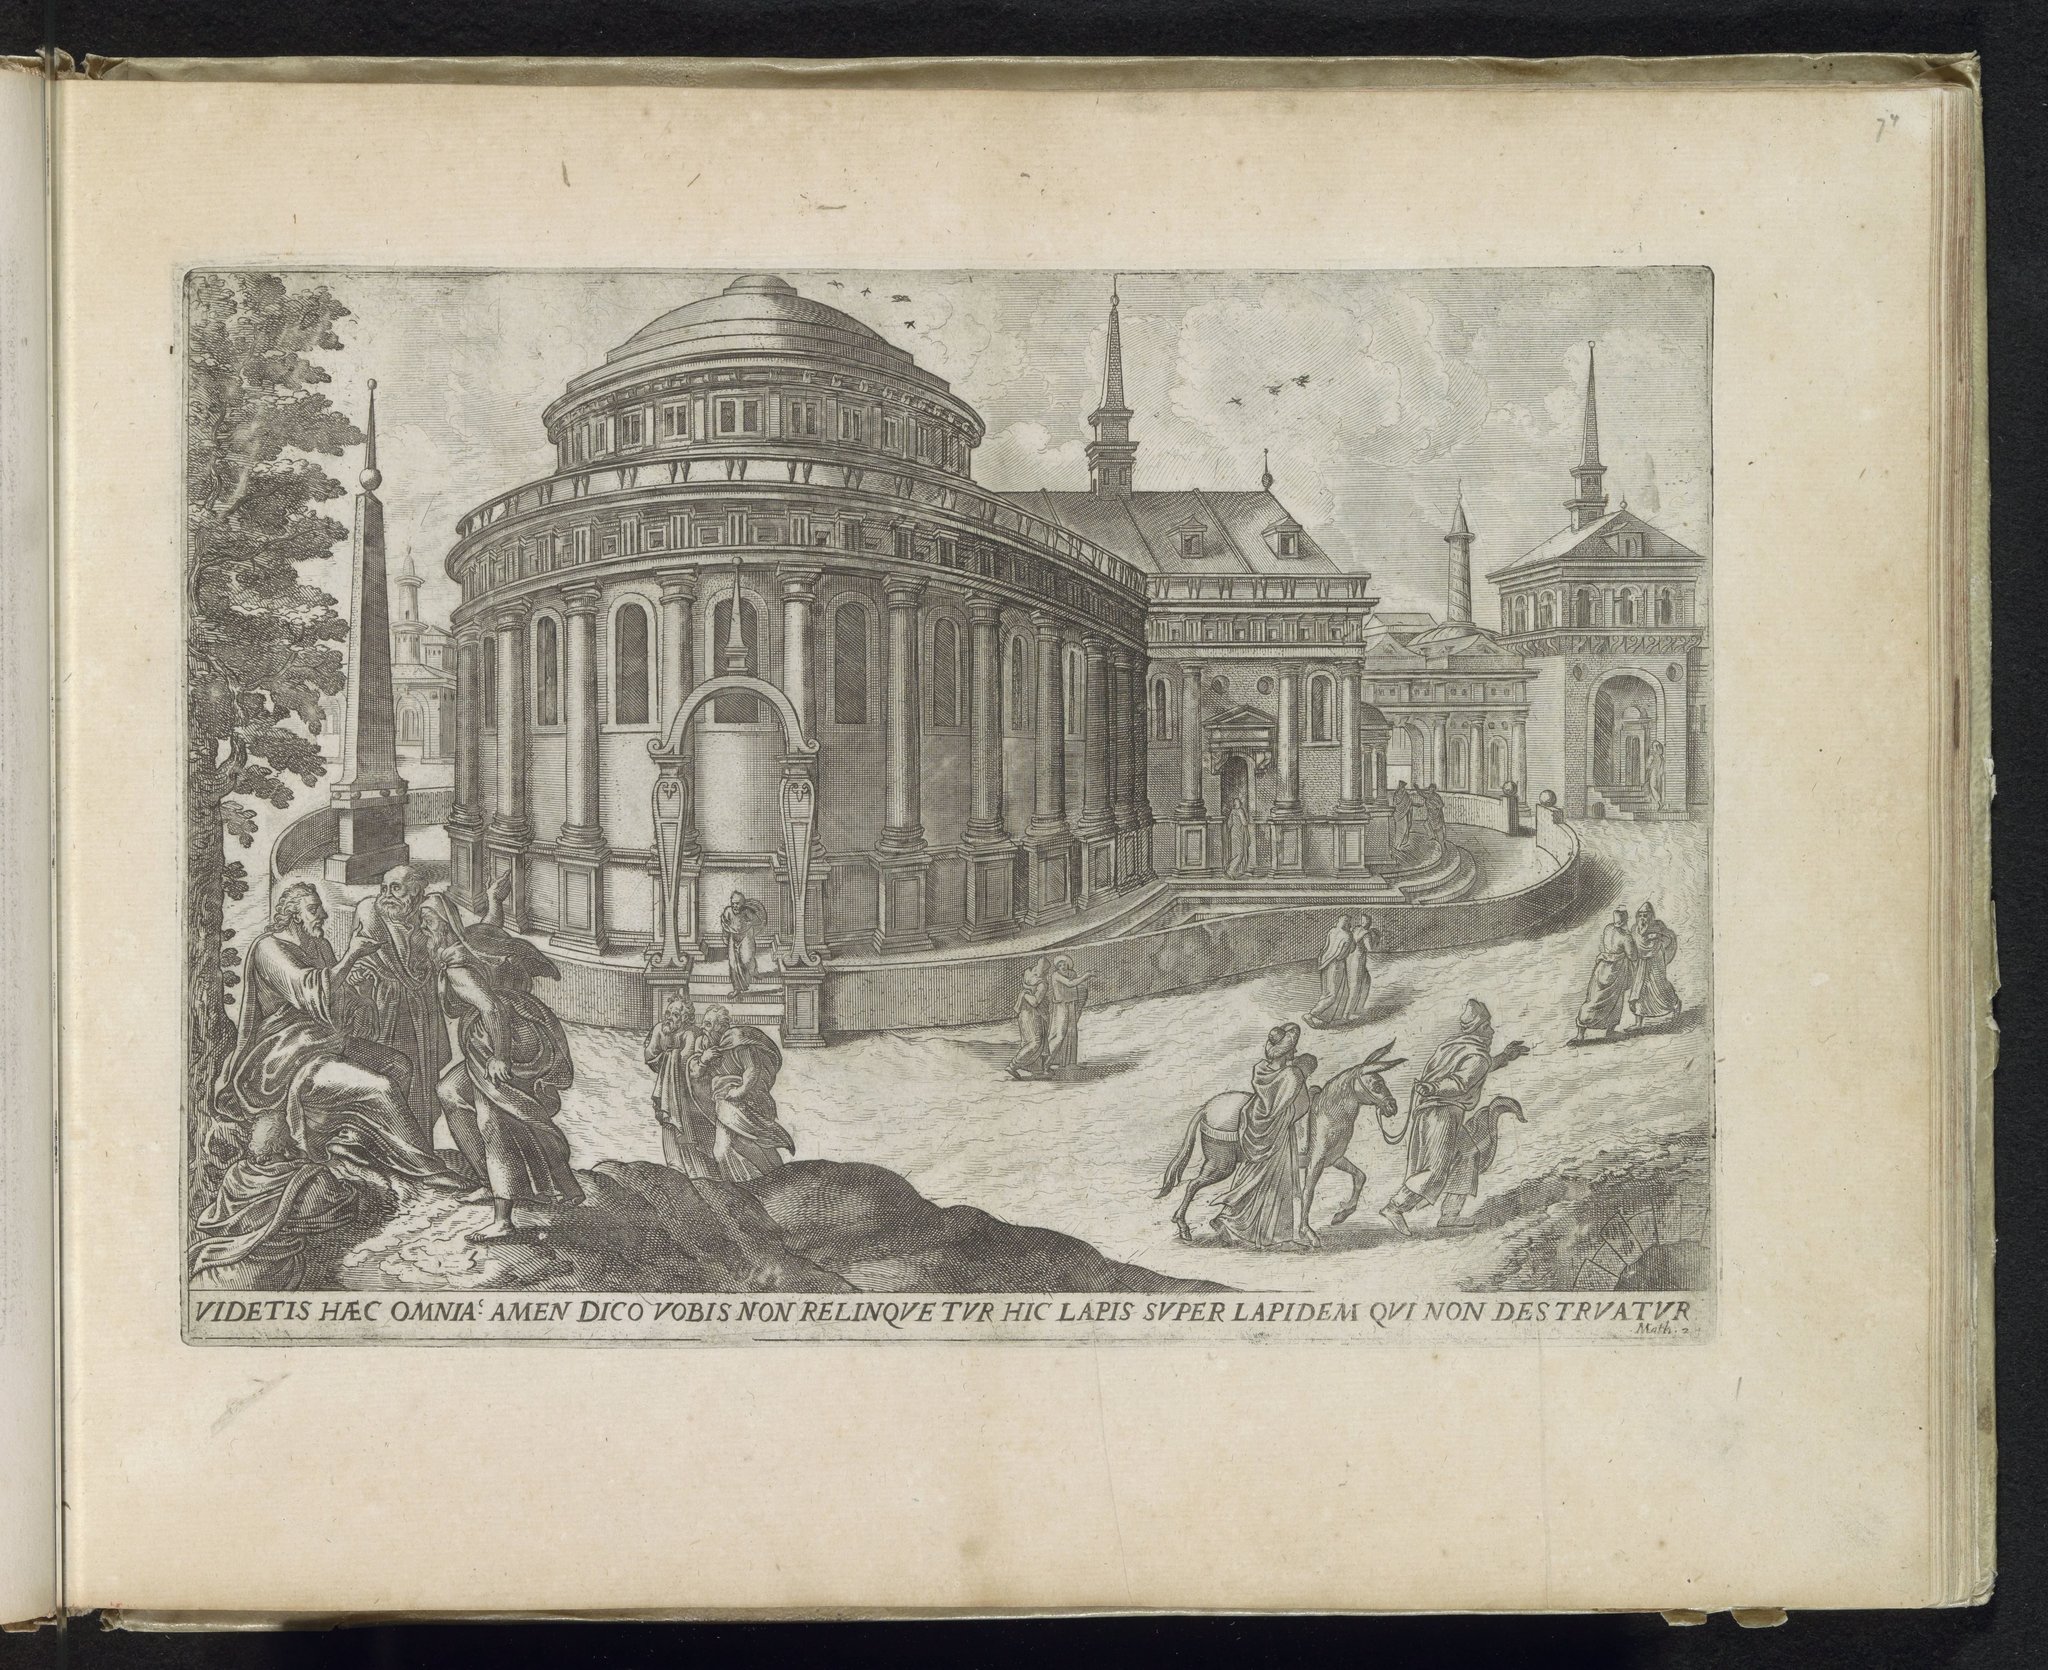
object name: album leaf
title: Christus voorspelt de verwoesting van de tempel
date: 1585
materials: paper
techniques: engraving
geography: antwerp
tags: sayings of christ: discourse on the last things (matthew 24; mark 13; luke 21)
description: Links op de voorgrond zit Christus. Hij vertelt zijn leerlingen, terwijl hij wijst op de tempelgebouwen, dat geen steen op de andere zal blijven staan. Onder de voorstelling een verwijzing in het Latijn naar de Bijbeltekst in Mat. 24. Onder de voorstelling een verwijzing in het Latijn naar de Bijbeltekst in Luc. 2. Deze prent maakt deel uit van een album.